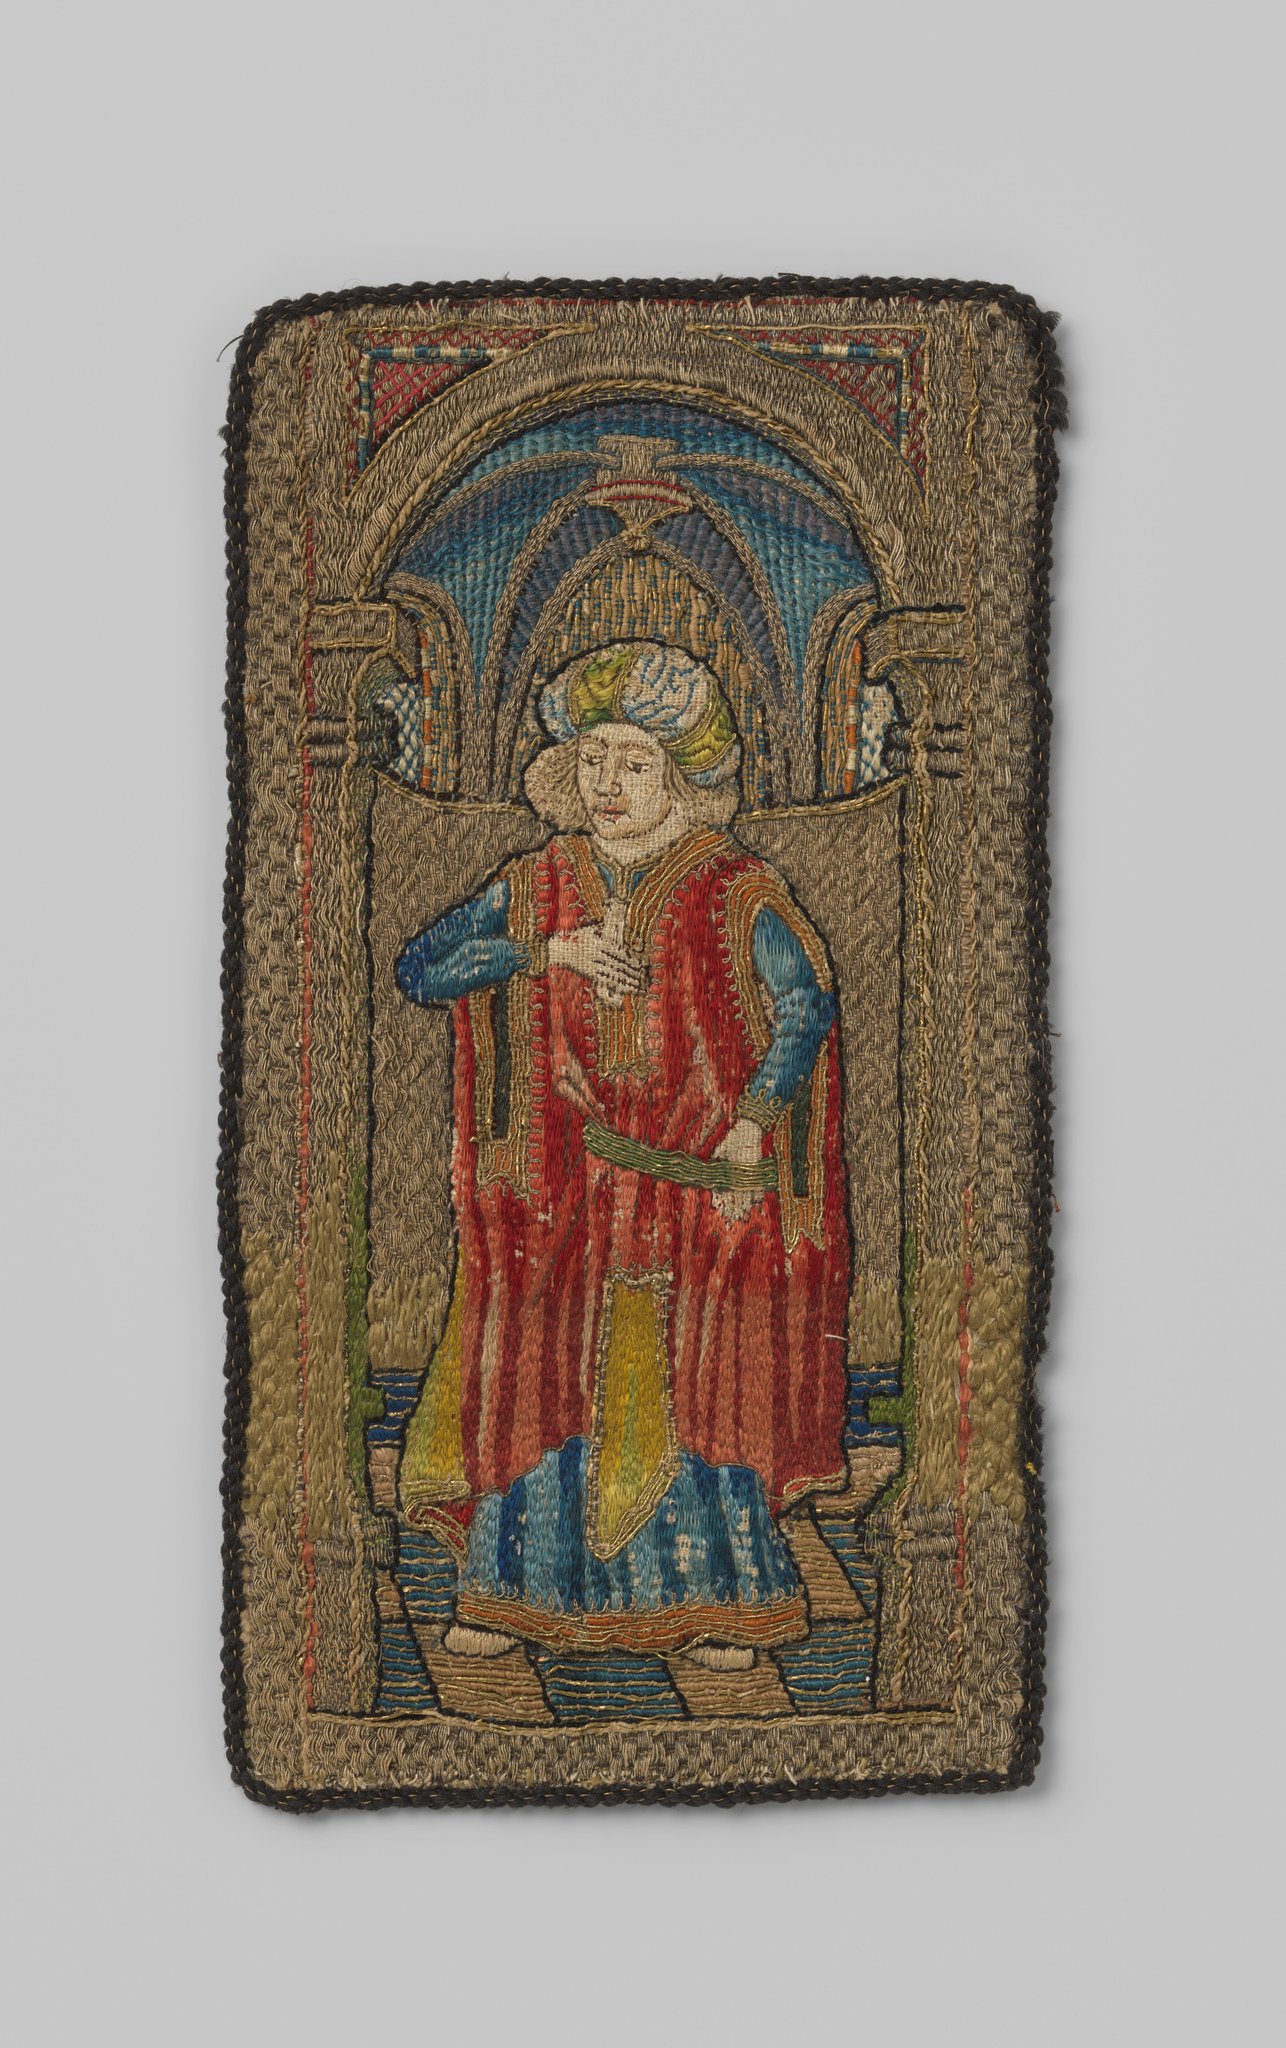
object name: aurifries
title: Fragment van een aurifries, met borduurwerk van zijde en goudraad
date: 1500-1525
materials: gold thread, silk, textile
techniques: embroidered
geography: southern netherlands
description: Fragment van een aurifries, met borduurwerk. Het patroon heeft een afbeelding van een baldakijn waaronder een profeet (zonder aureool, met een tulband, een rode mantel met wijde, lange mouwen en een blauw onderkleed). Bij het fragment hoort een fragment met invnr. BK-NM-4165-B-1.